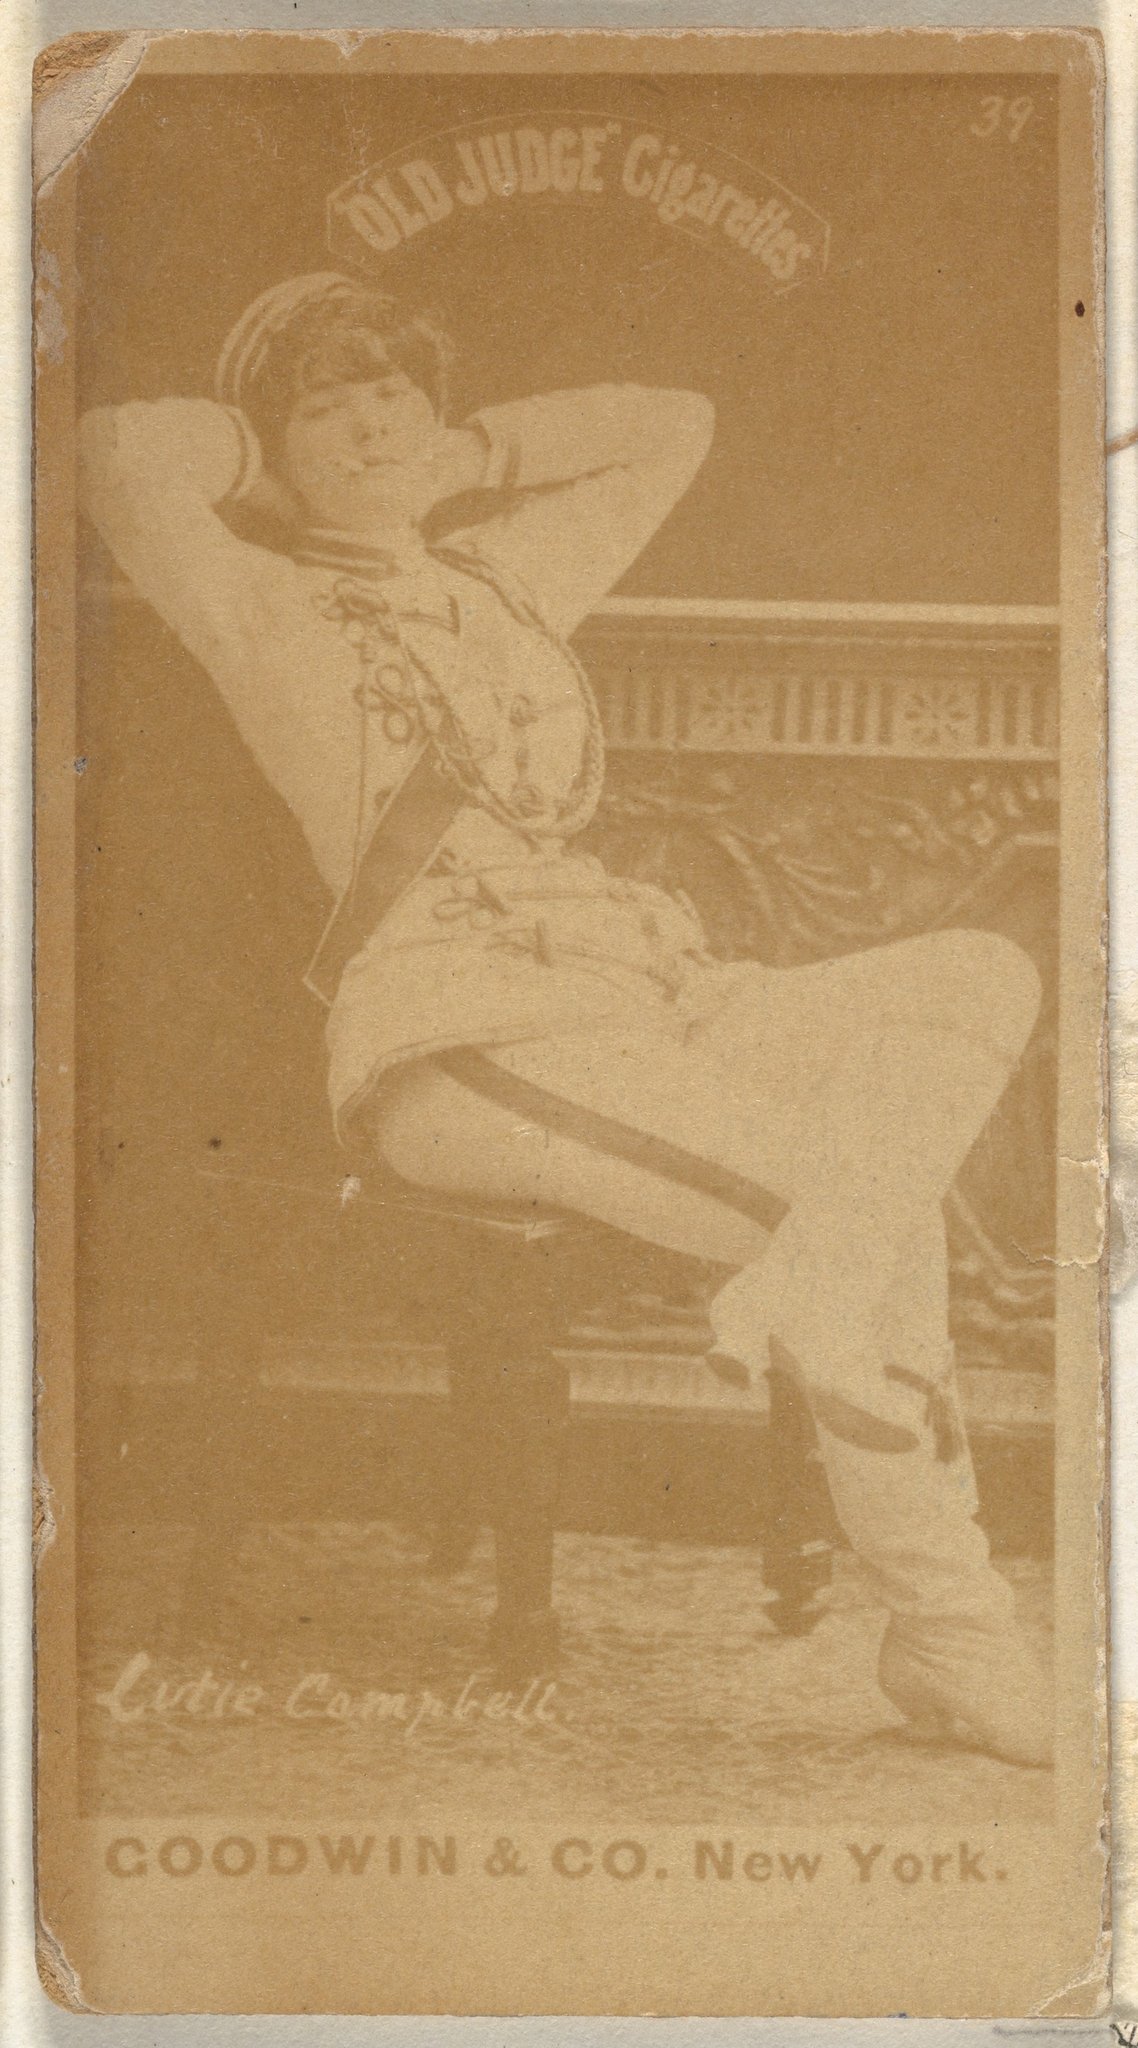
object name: photograph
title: Cutie Campbell, from the Actors and Actresses series (N171) for Old Judge Cigarettes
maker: goodwin & company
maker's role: publisher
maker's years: 1850-1950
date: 1886-1890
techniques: albumen silver print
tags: portraits,women,actresses